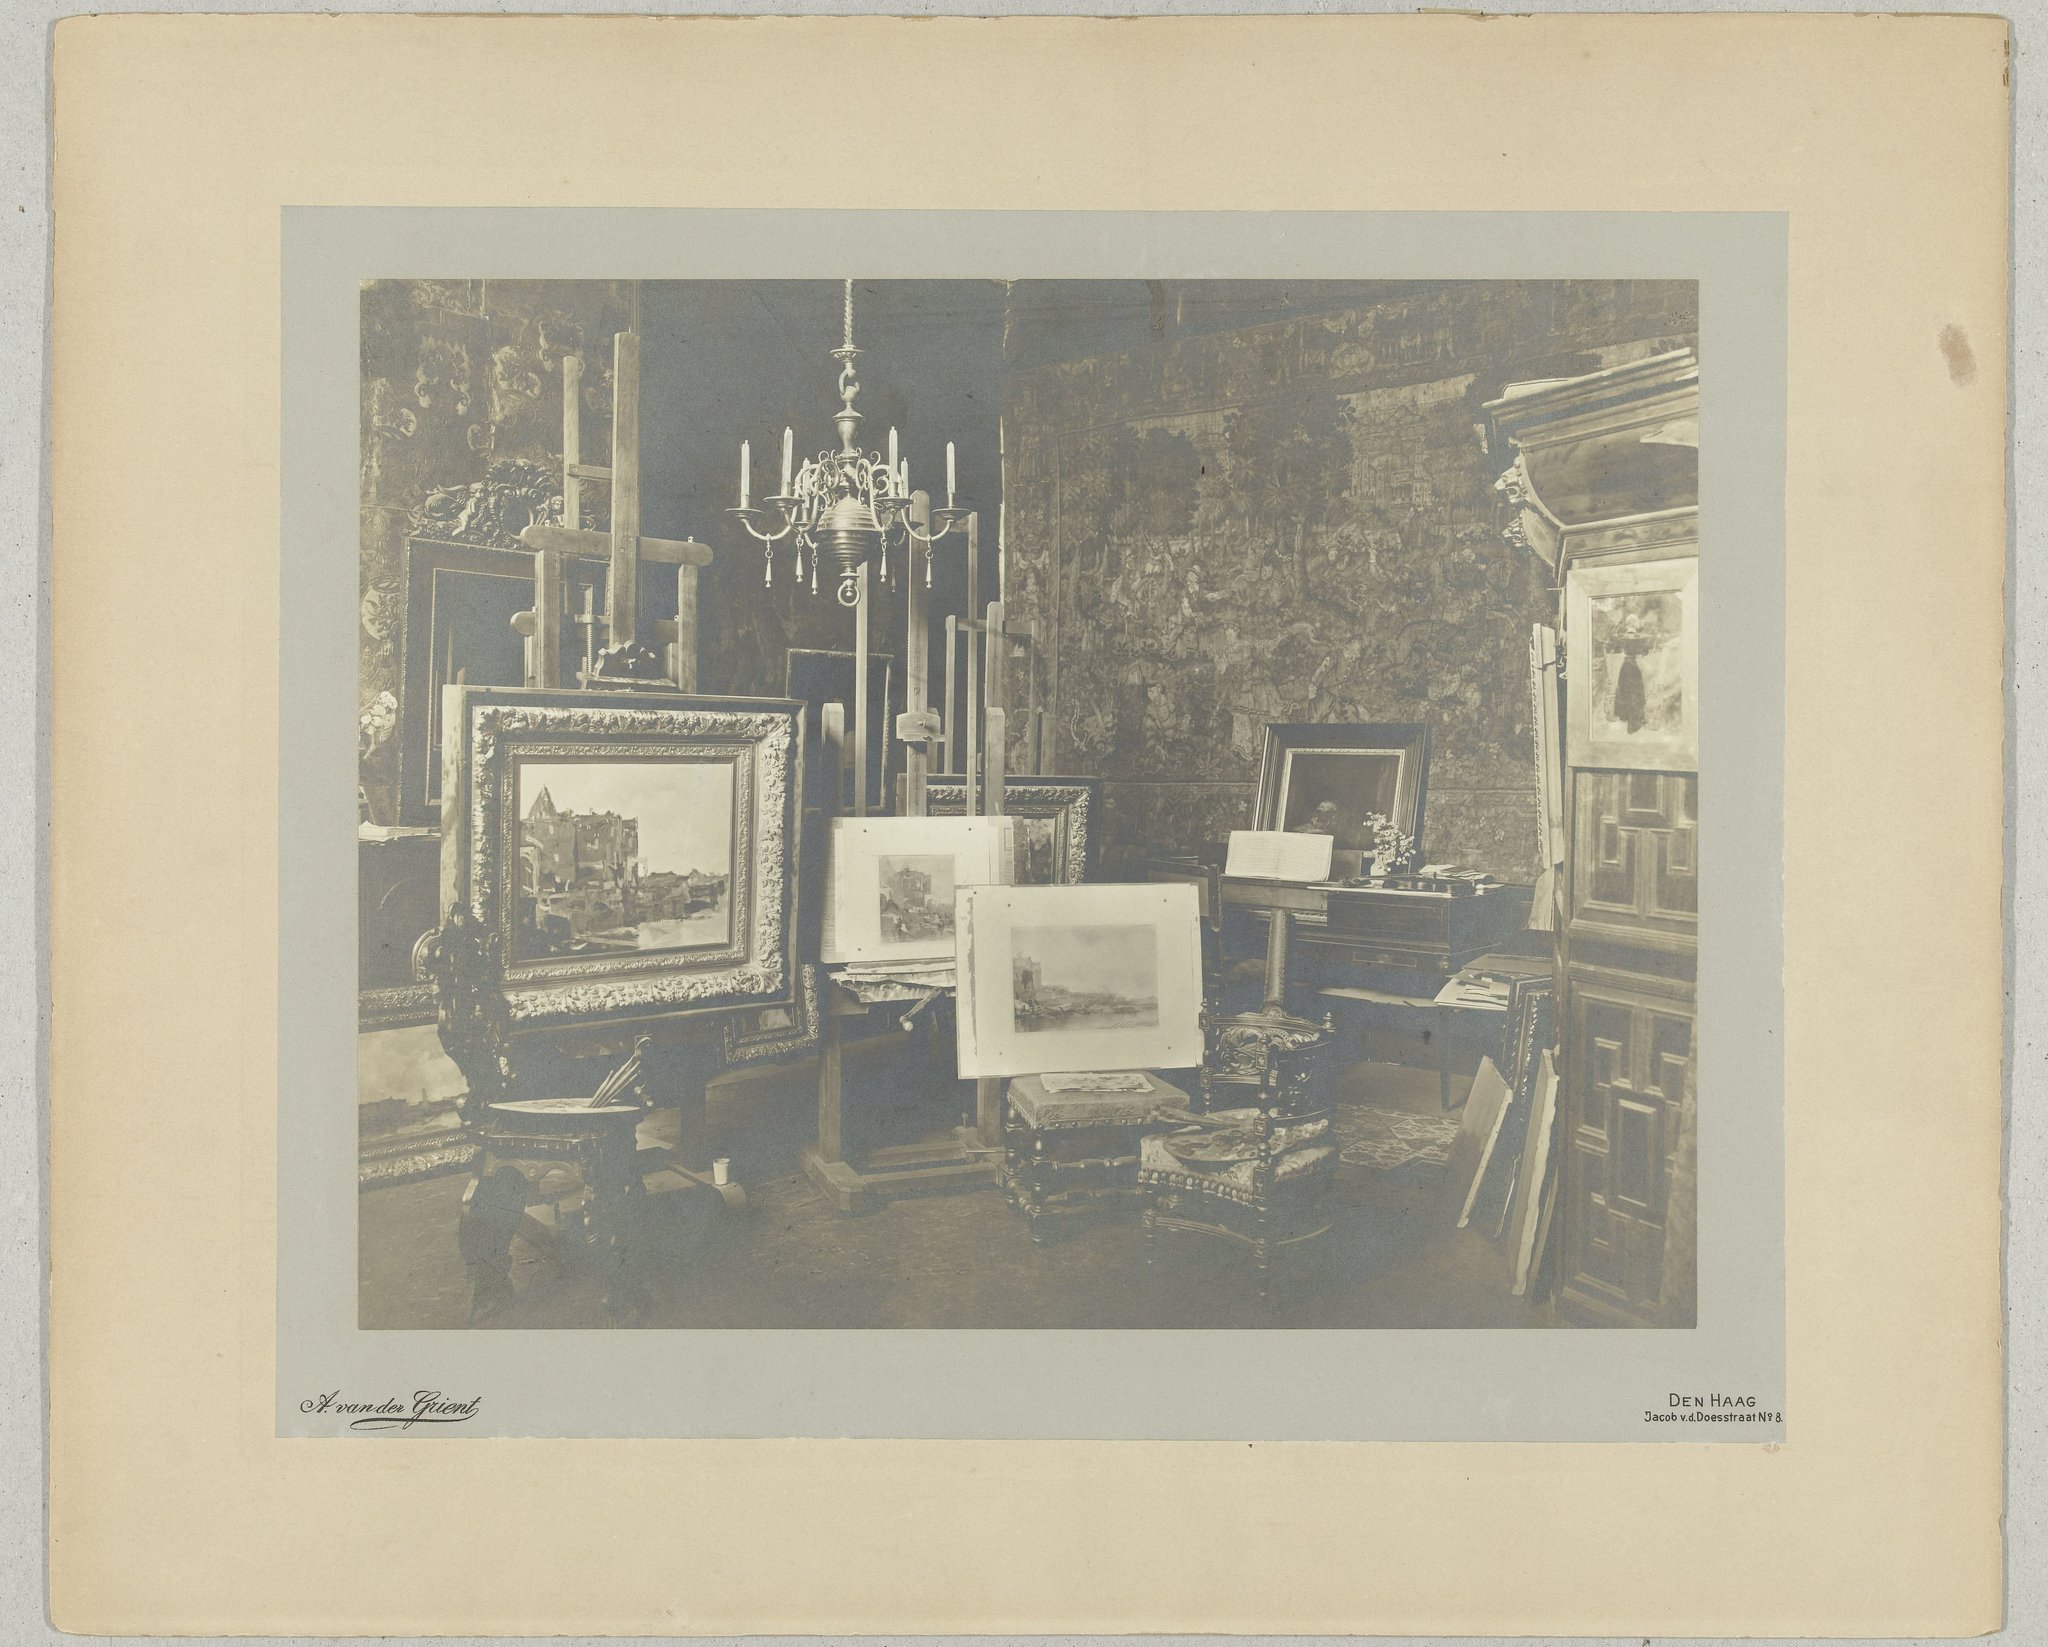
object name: photograph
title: Interieur van een schildersatelier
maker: adrianus van der grient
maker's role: fotograaf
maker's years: 1858-1941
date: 1890-1920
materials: cardboard, paper, photographic support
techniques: gelatin silver print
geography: the hague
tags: workshop, studio of the artist (in general), netherlands